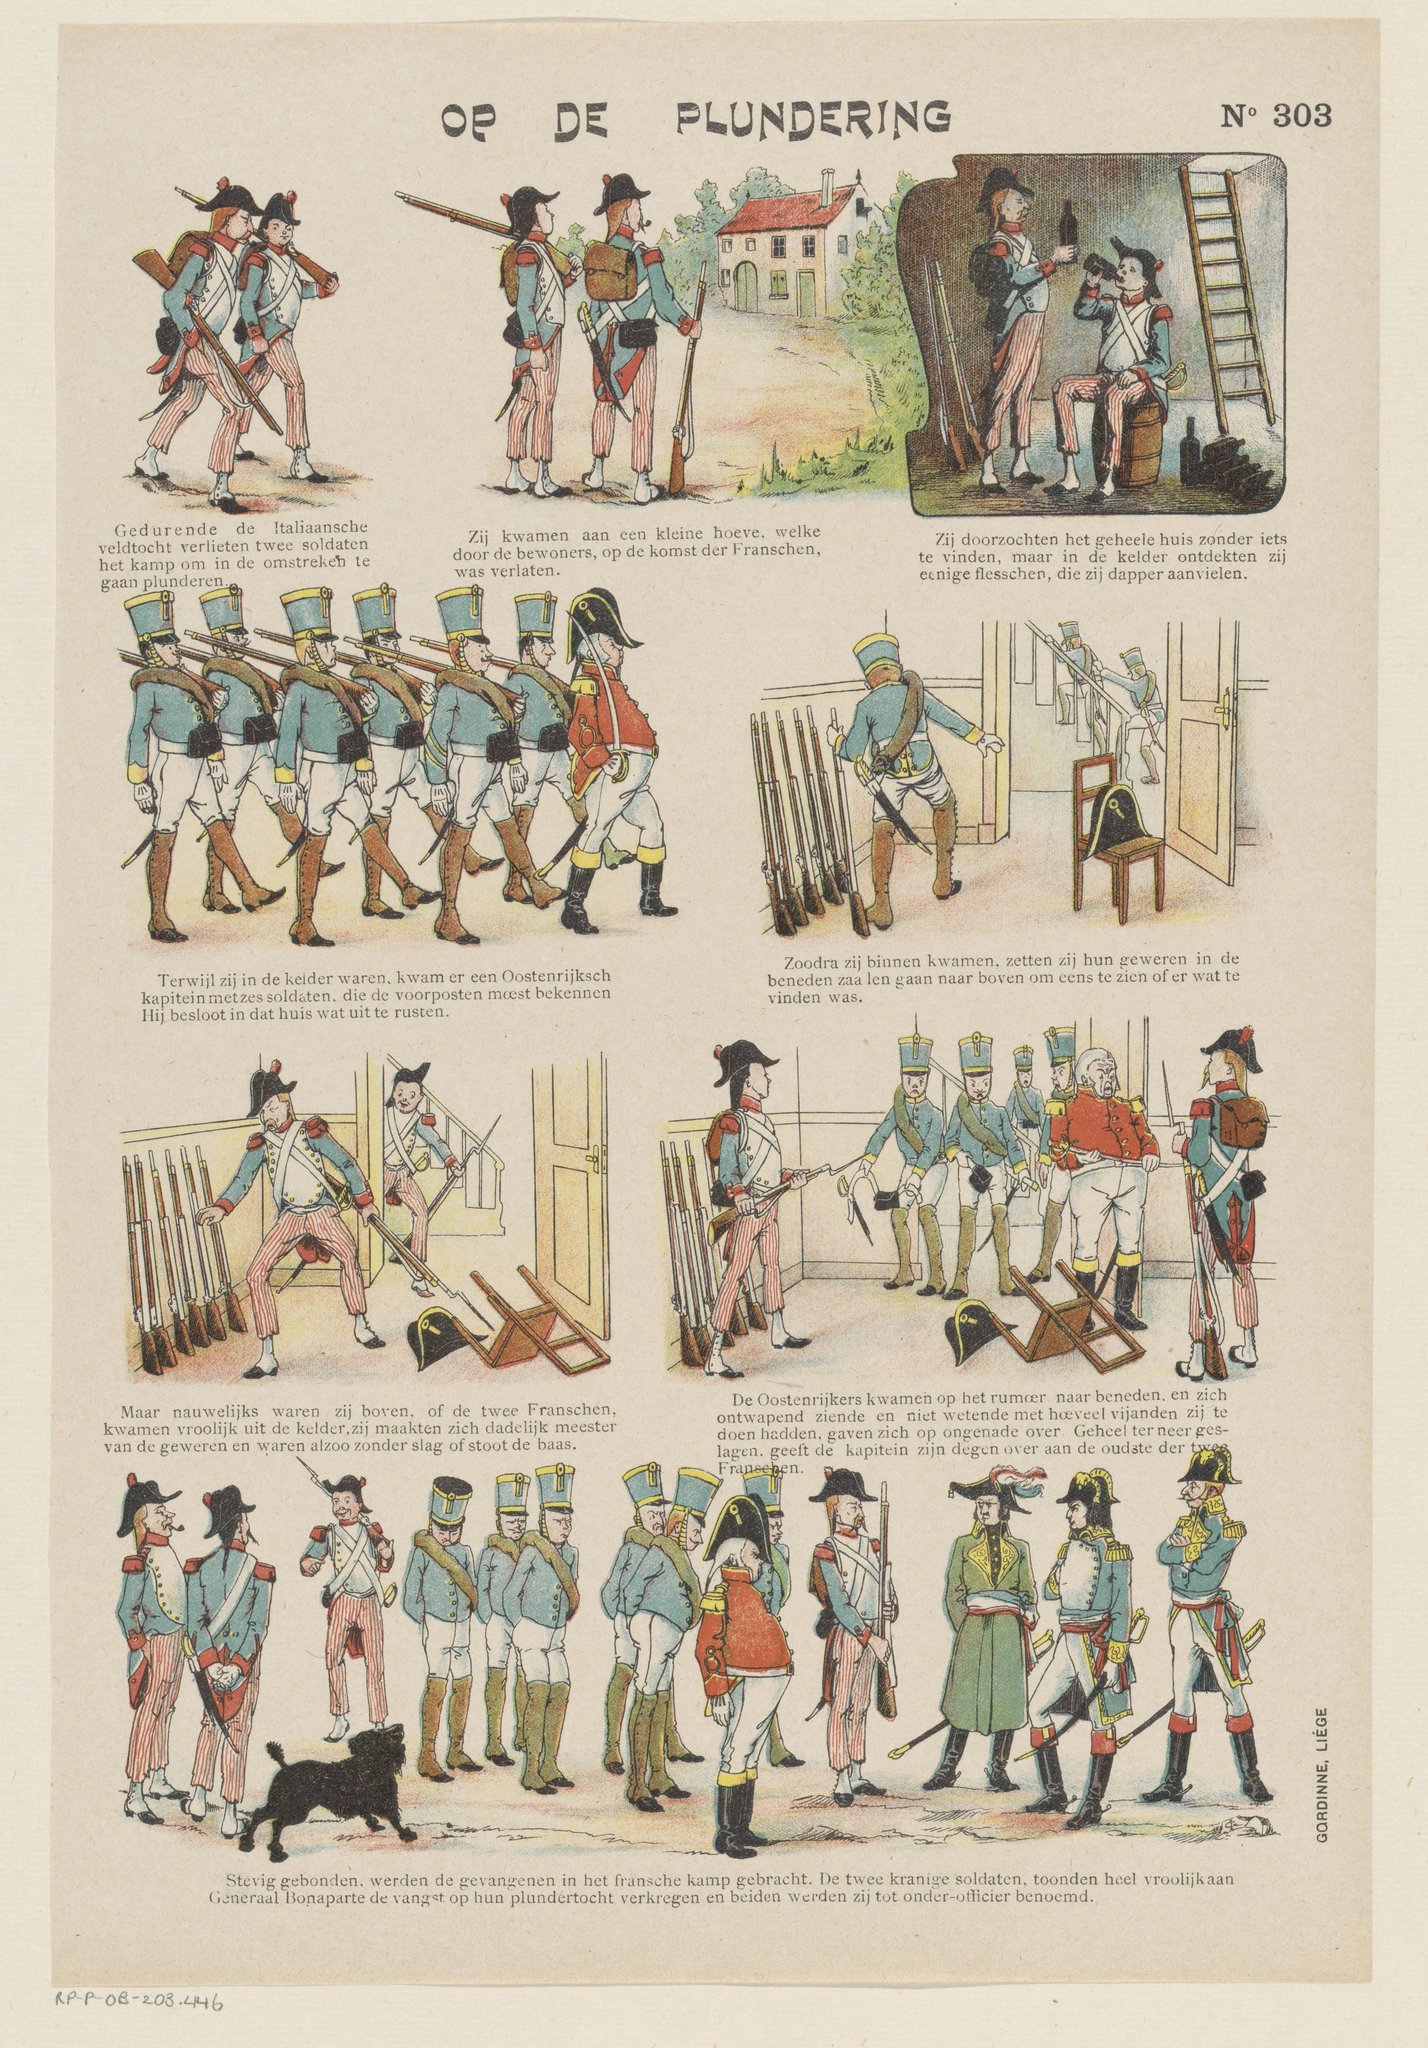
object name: popular print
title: Op de plundering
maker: Anonymous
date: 1894-1959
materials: paper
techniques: lithograph, letterpress printing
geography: liège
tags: napoleon i (emperor of the french), the soldier; the soldier's life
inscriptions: collector's mark: Lugt 2760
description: Blad met 8 voorstellingen over twee Franse soldaten die per ongeluk een Oostenrijkse kapitein en zes soldaten gevangennemen. Napoleon I Bonaparte benoemt de twee tot onderofficier. Onder elke afbeelding een onderschrift. Genummerd rechtsboven: No 303.